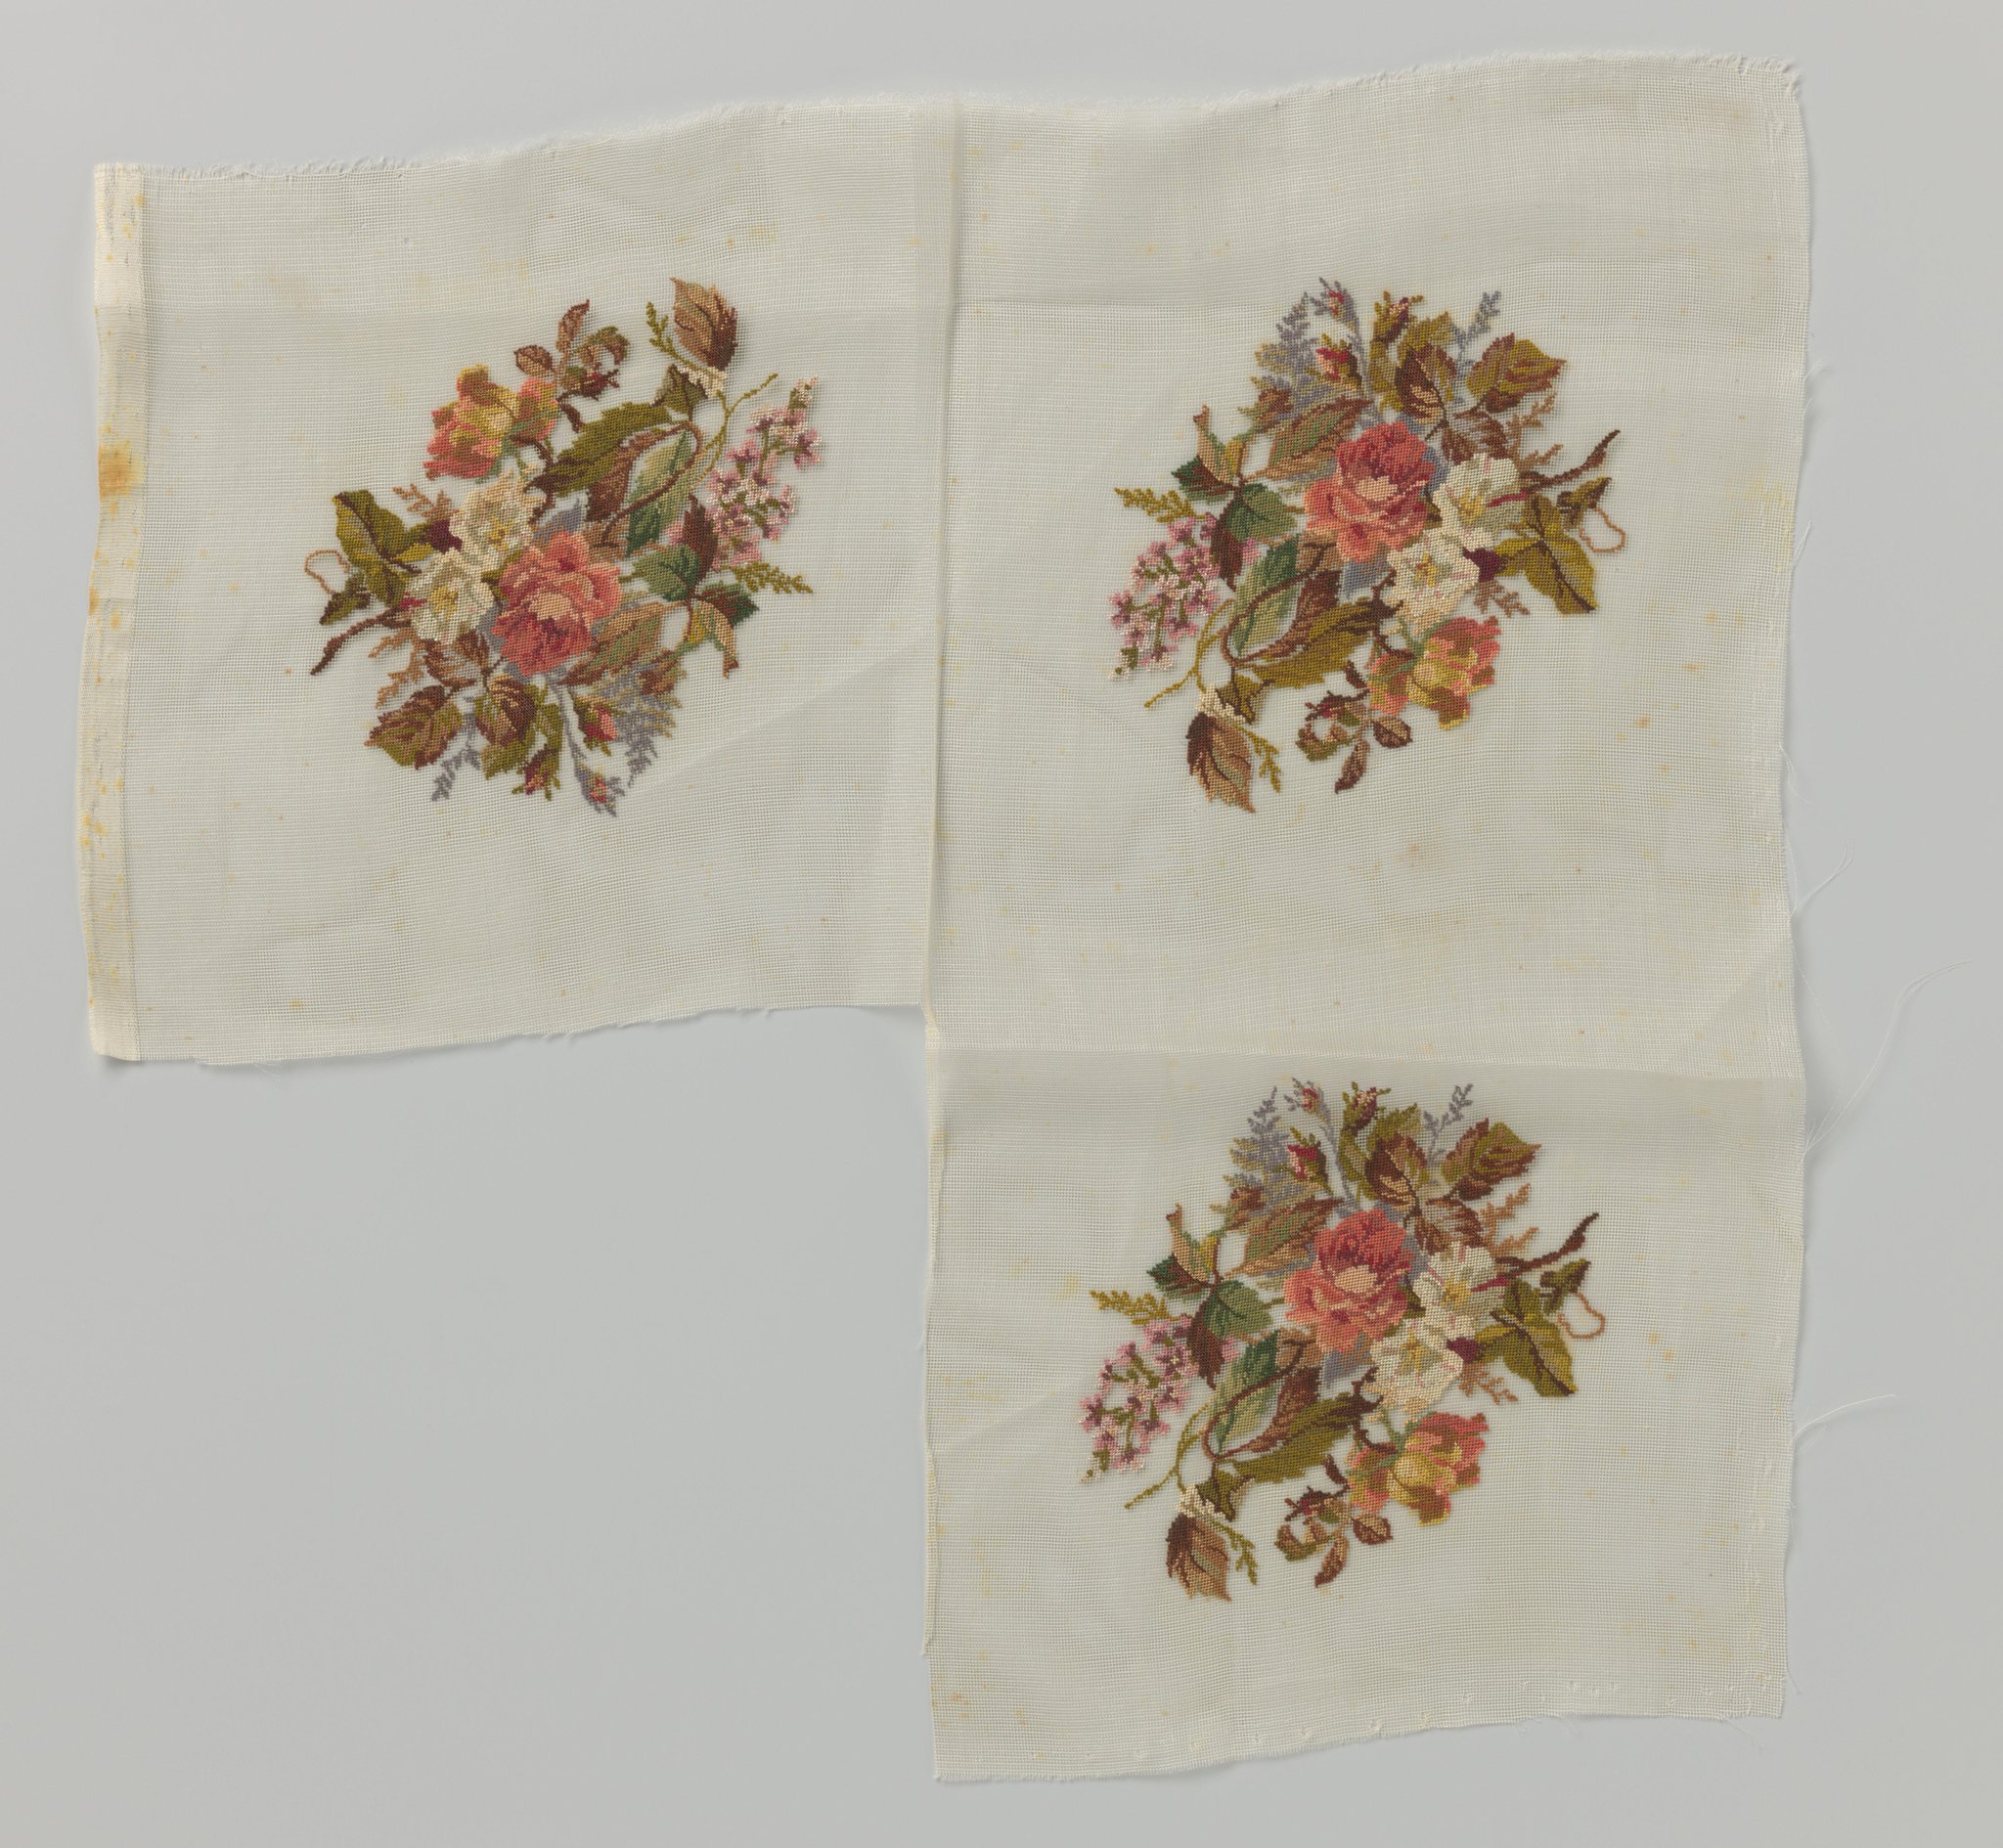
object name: embroidery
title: Borduurwerk van drie bloemboeketjes op gaas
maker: Anonymous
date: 1900-1949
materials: silk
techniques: embroidered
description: Borduurwerk van drie bloemboeketjes op gaas.